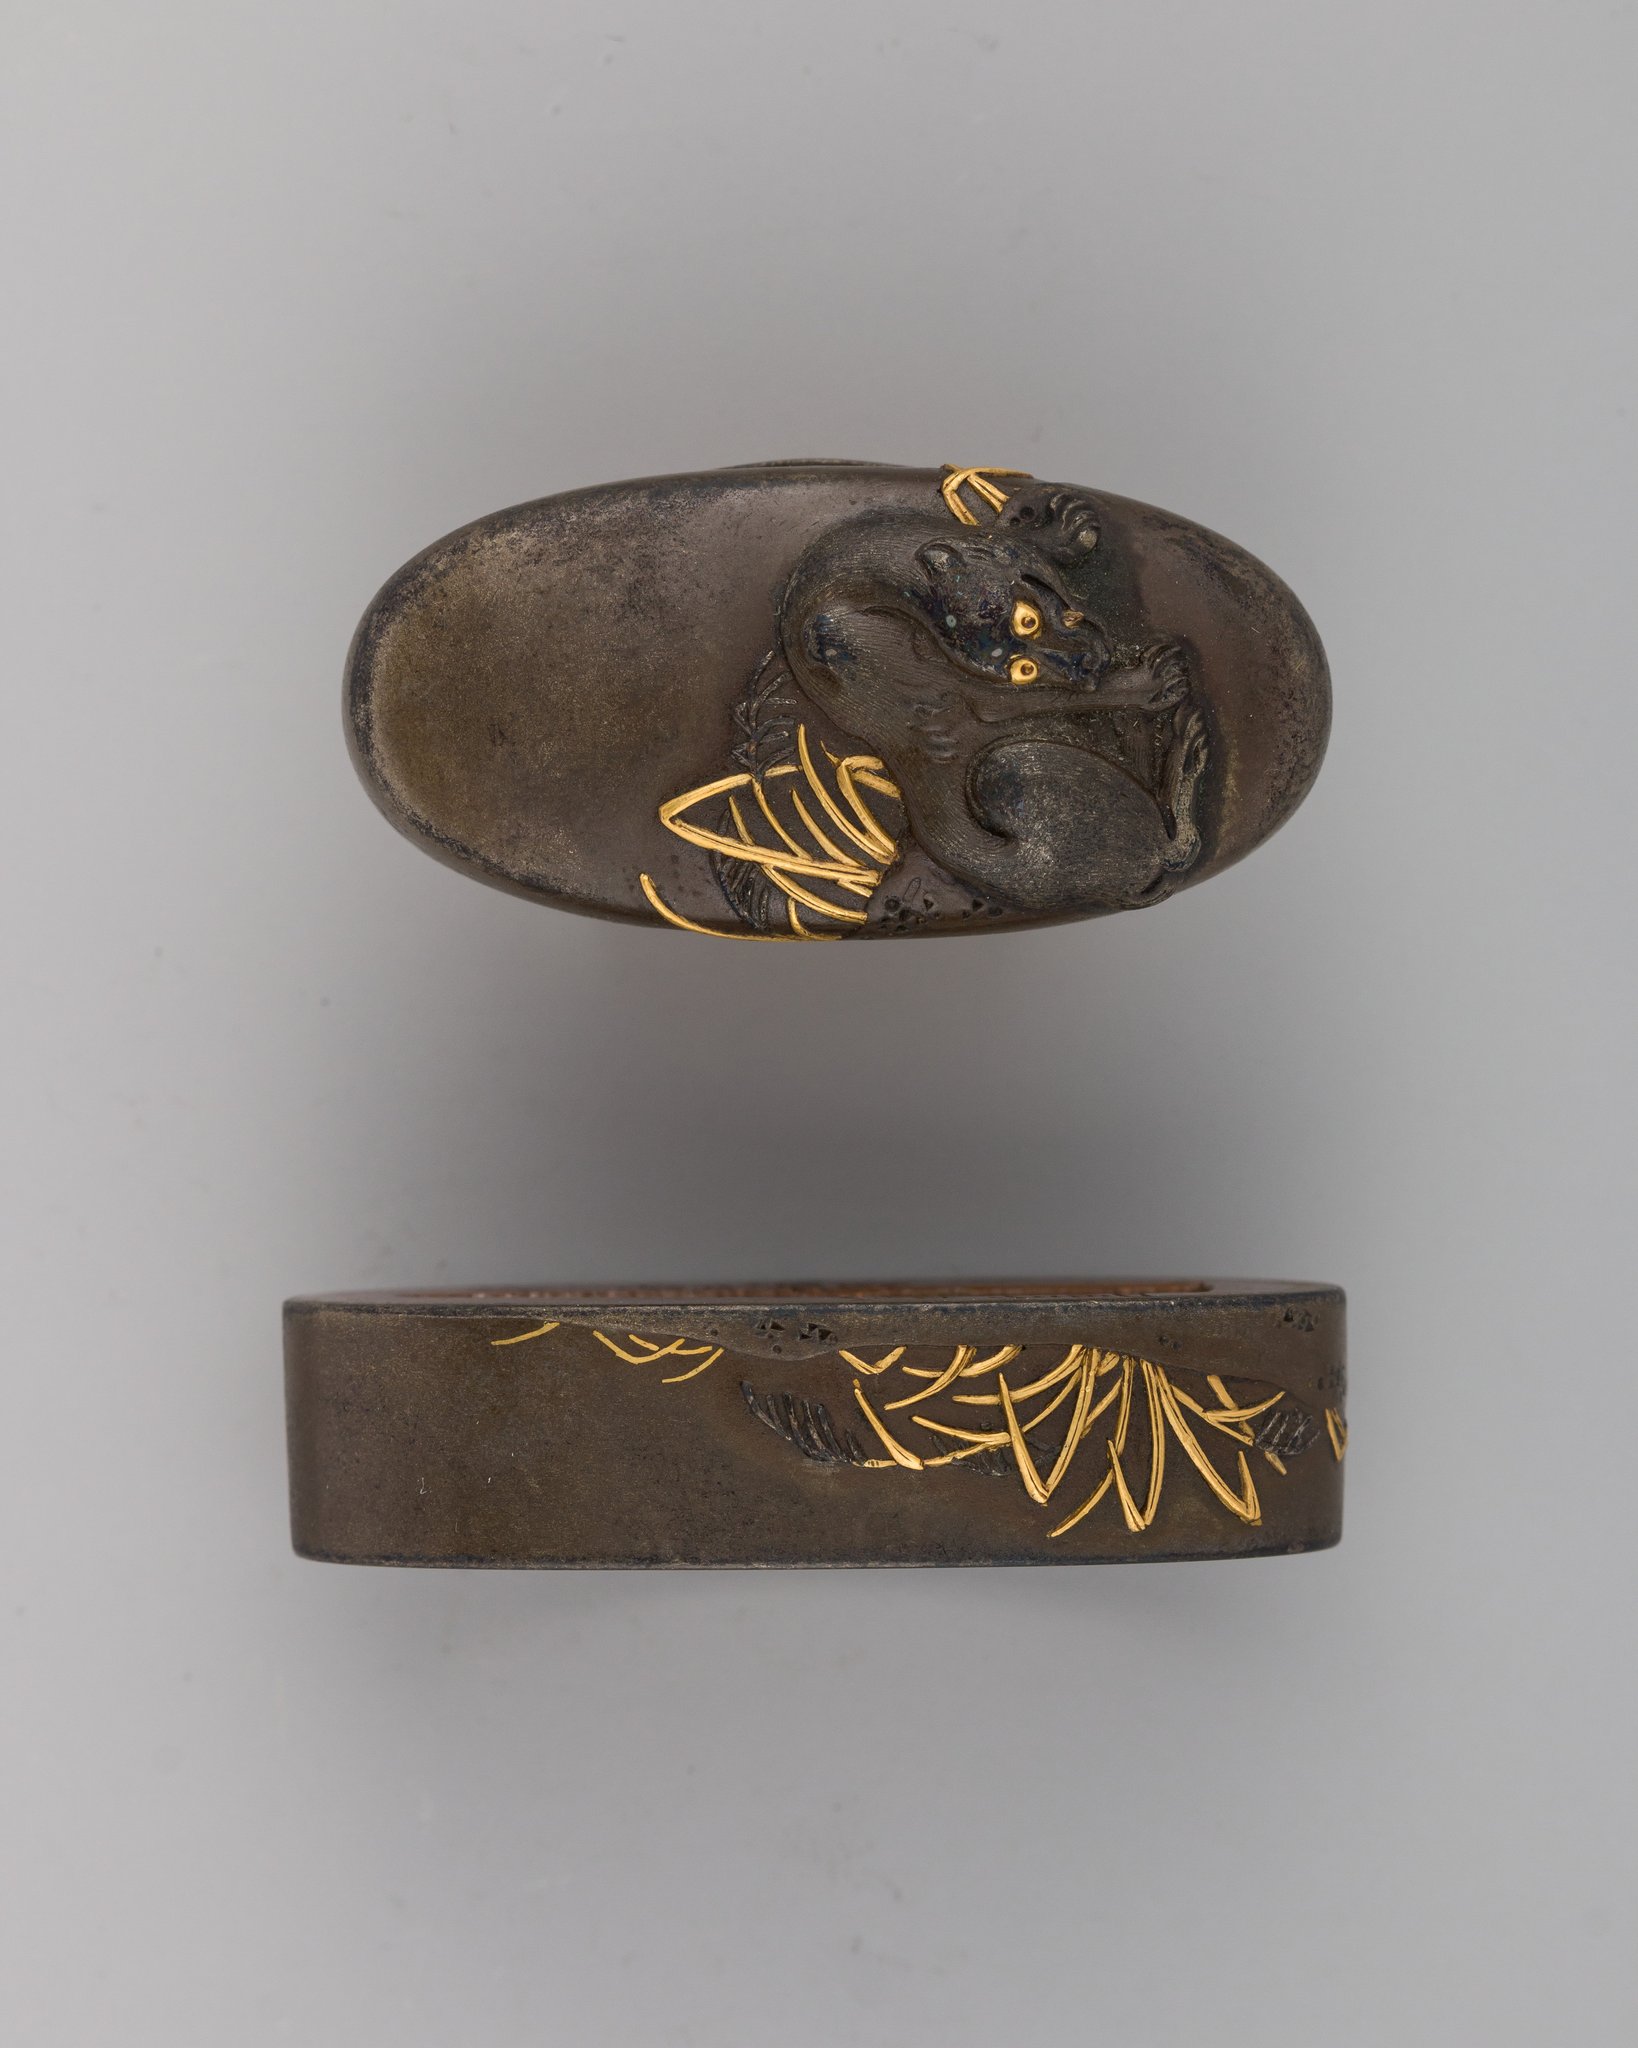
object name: sword hilt collar and pommel fuchigashira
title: Sword-Hilt Collar and Pommel (Fuchigashira)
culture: japanese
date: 1615-1868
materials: silver alloy, gold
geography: japan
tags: animals,plants